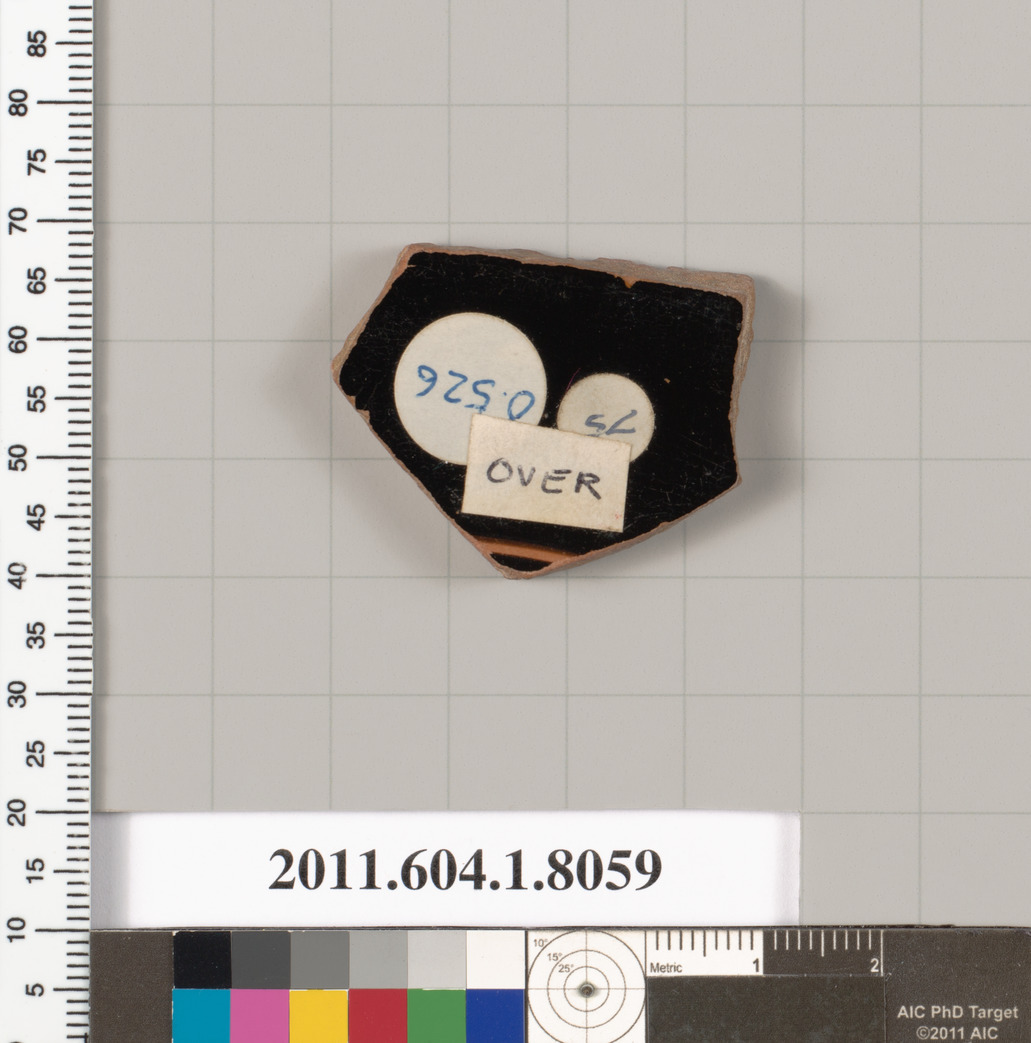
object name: kylix fragment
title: Terracotta fragment of a kylix (drinking cup)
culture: greek, attic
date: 510-500 BCE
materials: terracotta